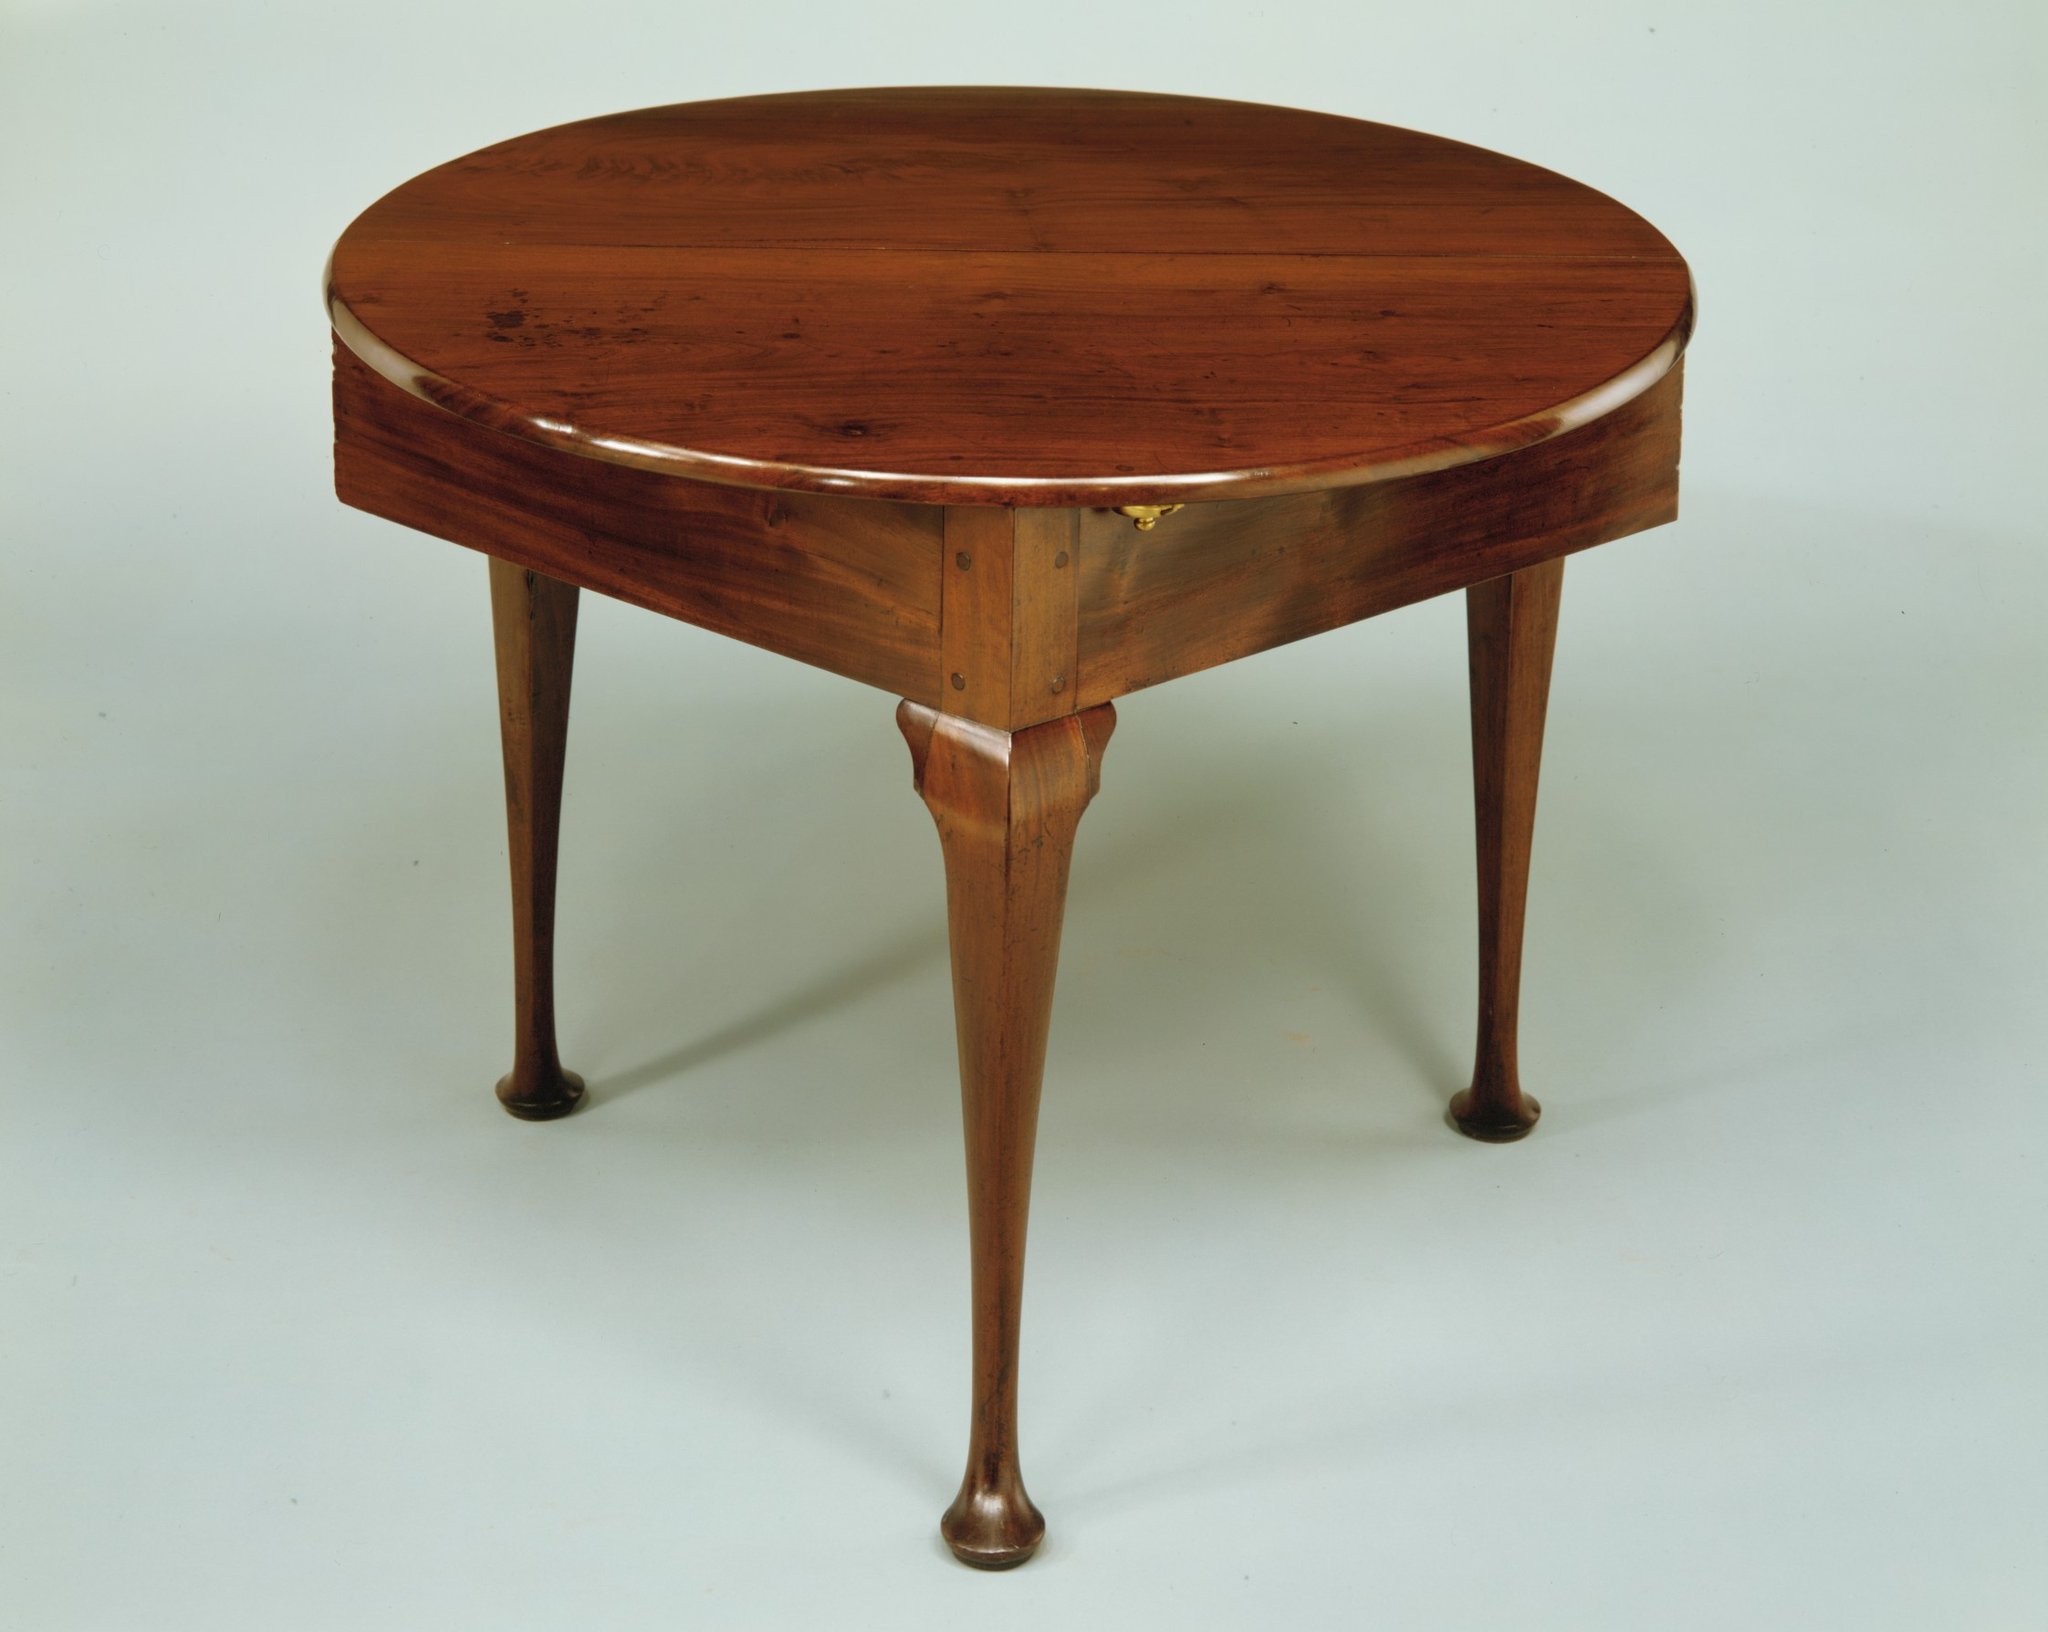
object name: card table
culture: american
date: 1740-1760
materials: wood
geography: united states